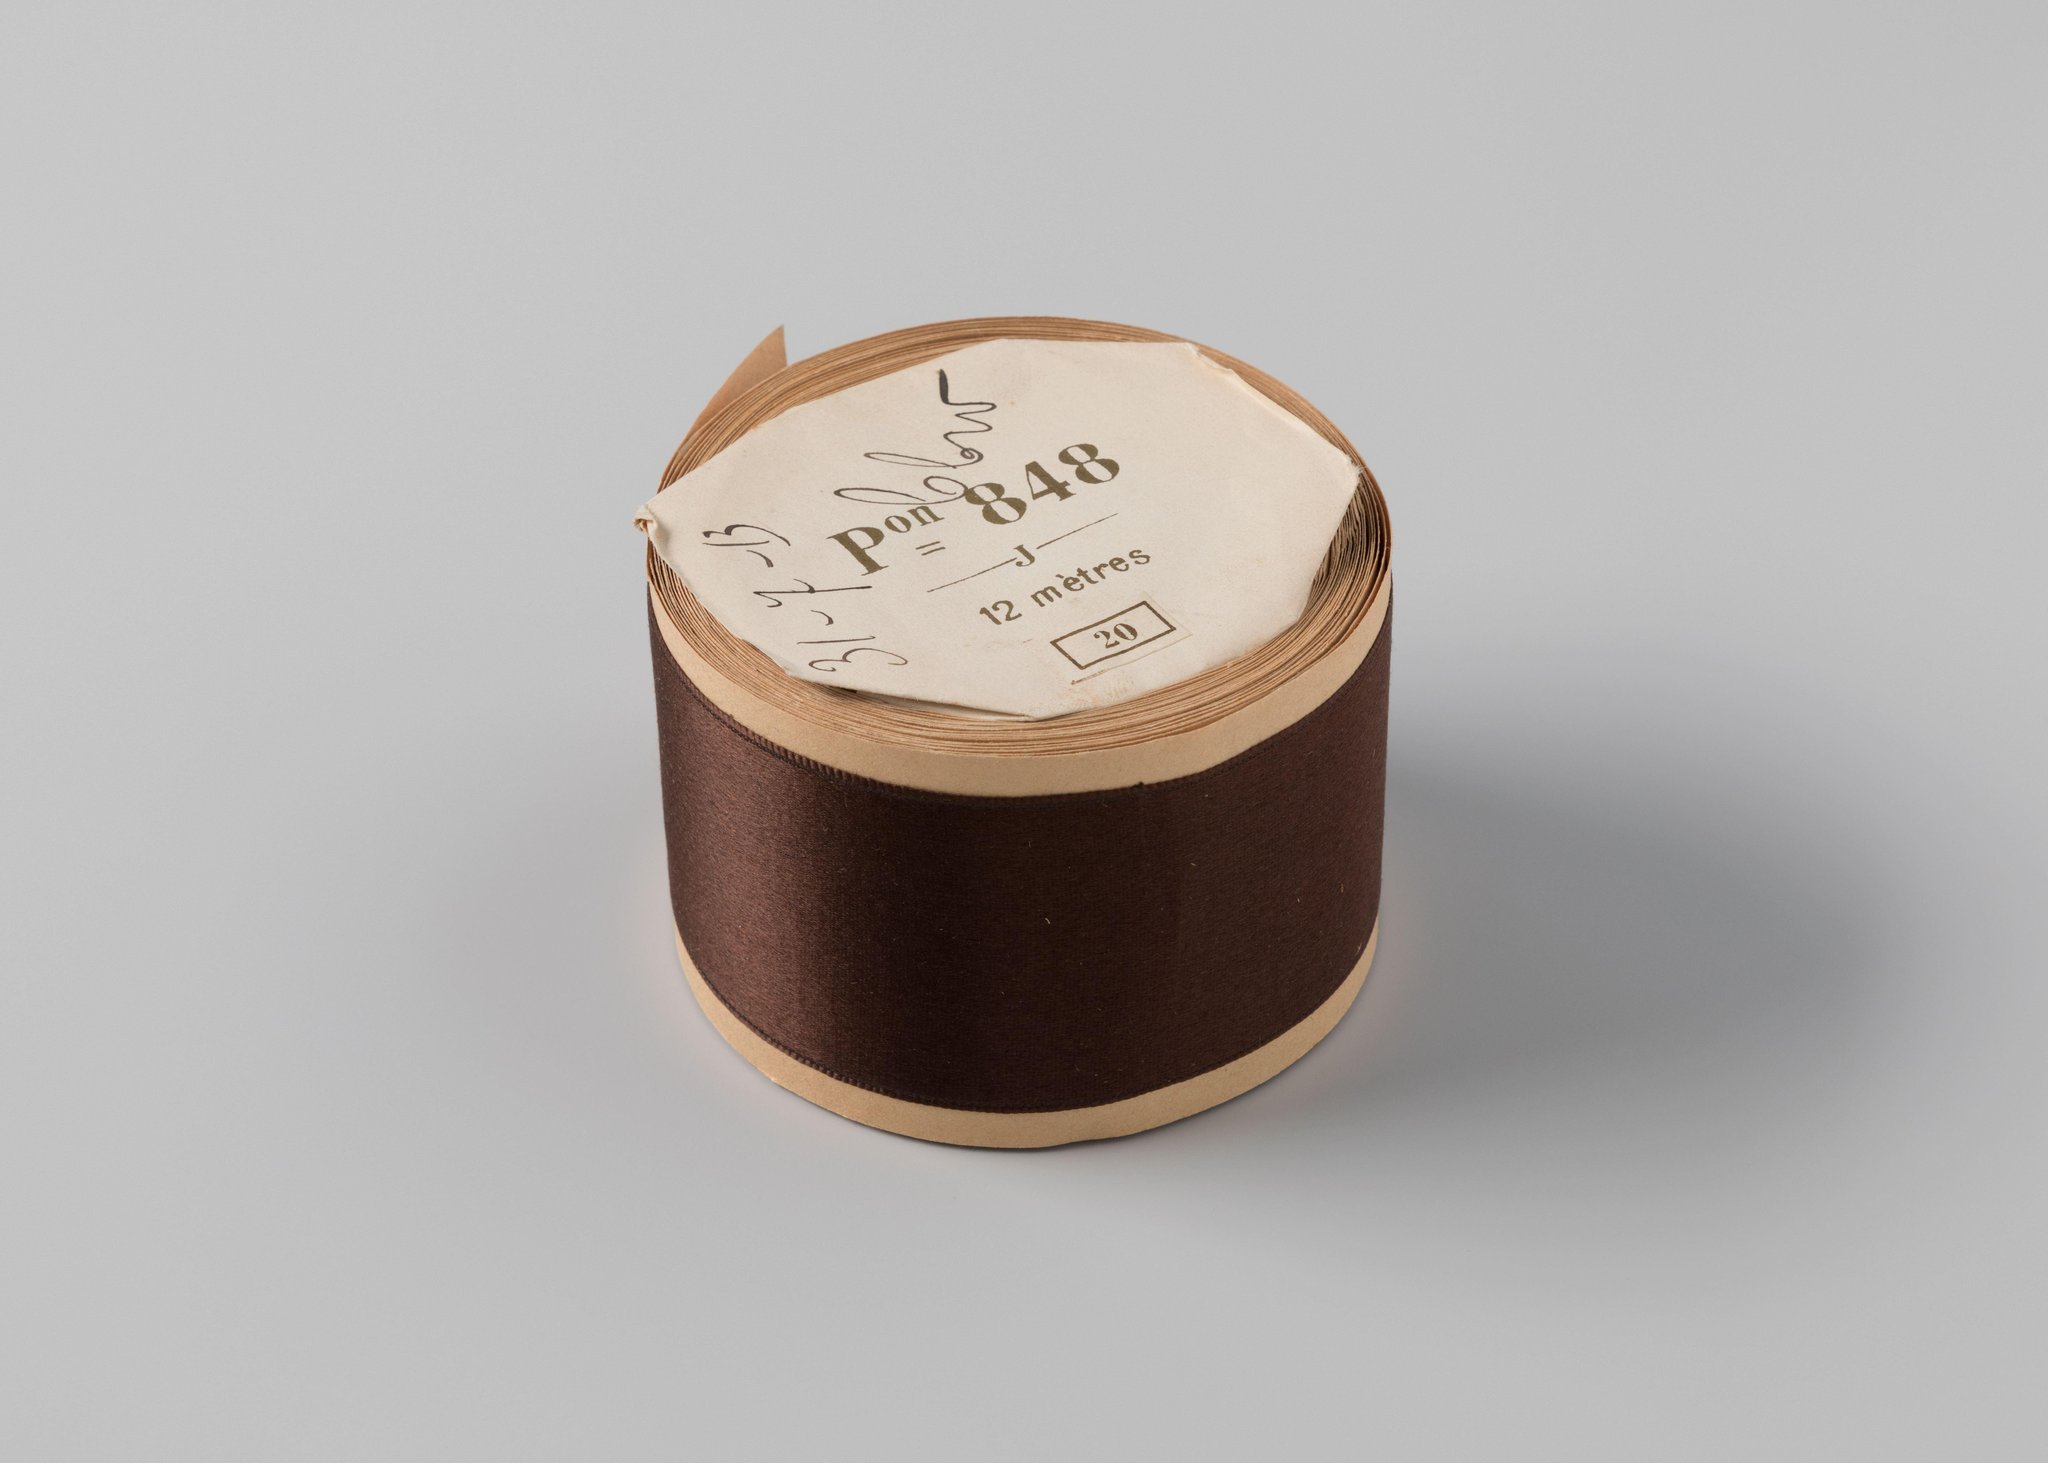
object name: ribbon material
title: Rol met donkerbruin zijden satijnlint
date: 1925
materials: cardboard, silk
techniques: satin binding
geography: france